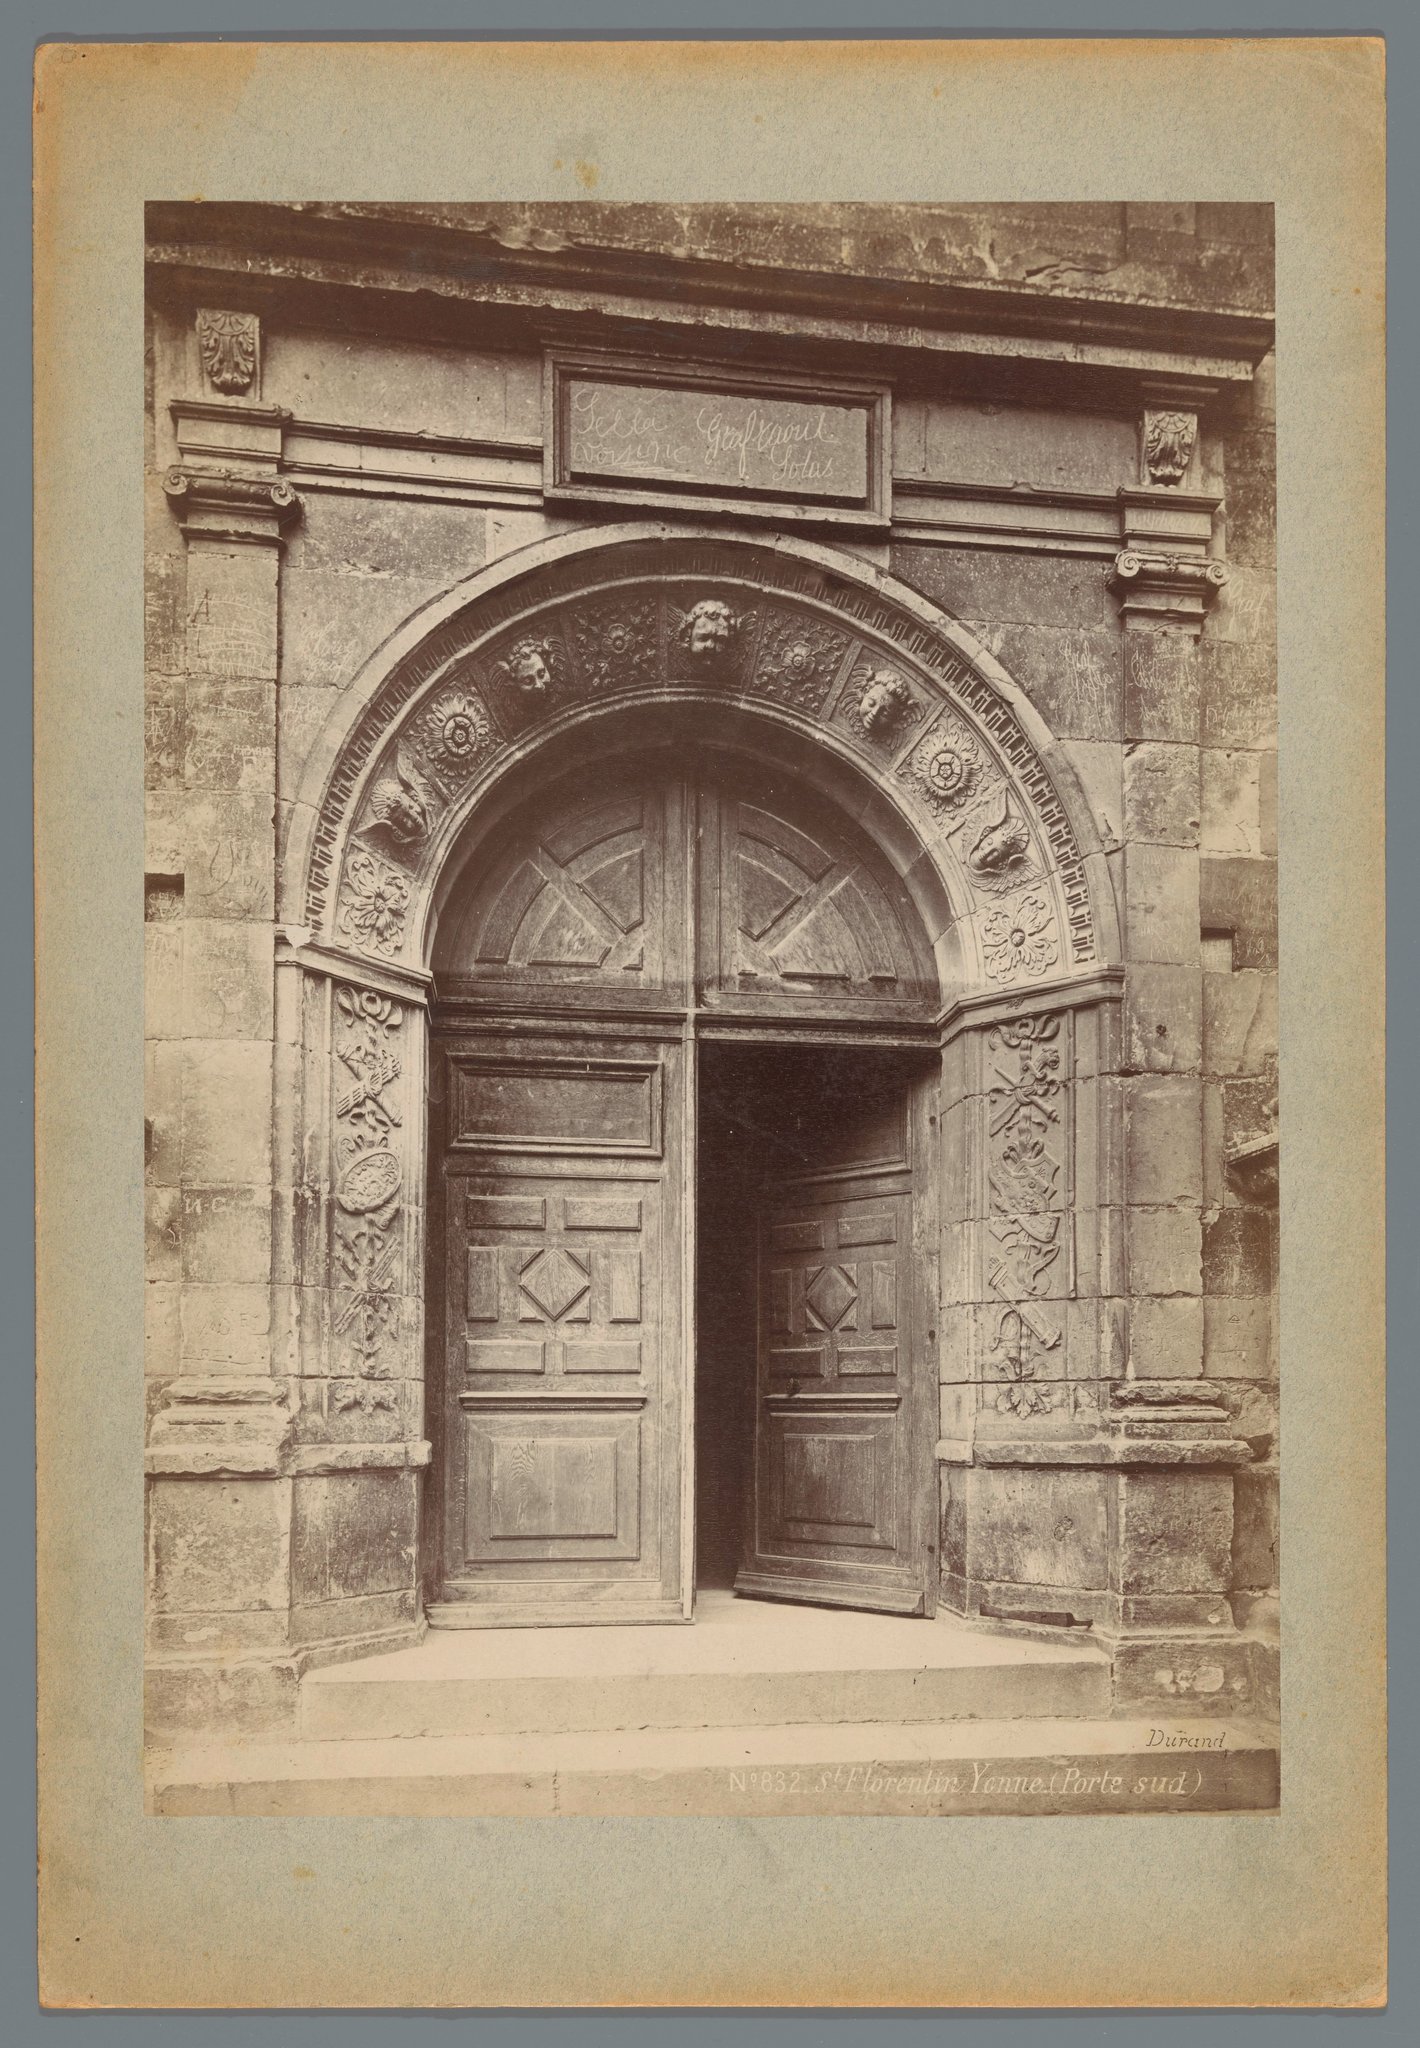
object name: photograph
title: Zuidelijk toegangsportaal van de kerk Saint-Florentin te Saint-Florentin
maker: séraphin-médéric mieusement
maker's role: fotograaf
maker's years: 1840-1905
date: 1875-1900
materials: cardboard, photographic support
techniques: albumen print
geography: burgundy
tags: cherubs, i.e. children's heads with wings, church (exterior), gate, entrance, sculpture (+ relief ~ sculpture)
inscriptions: name: ‘MIEUSEMENT PHOTOGRAPHE’, collector's mark: Lugt 3937, name: ‘Durand’, name: ‘KUNSTBOEKHANDEL J. A. G. DE LEUR PHOTOGRAAF - UITGEVER Huigenspark, 40b. DEN HAAG’, name: ‘MONUMENTS HISTORIQUES’, number: ‘No. 832.’